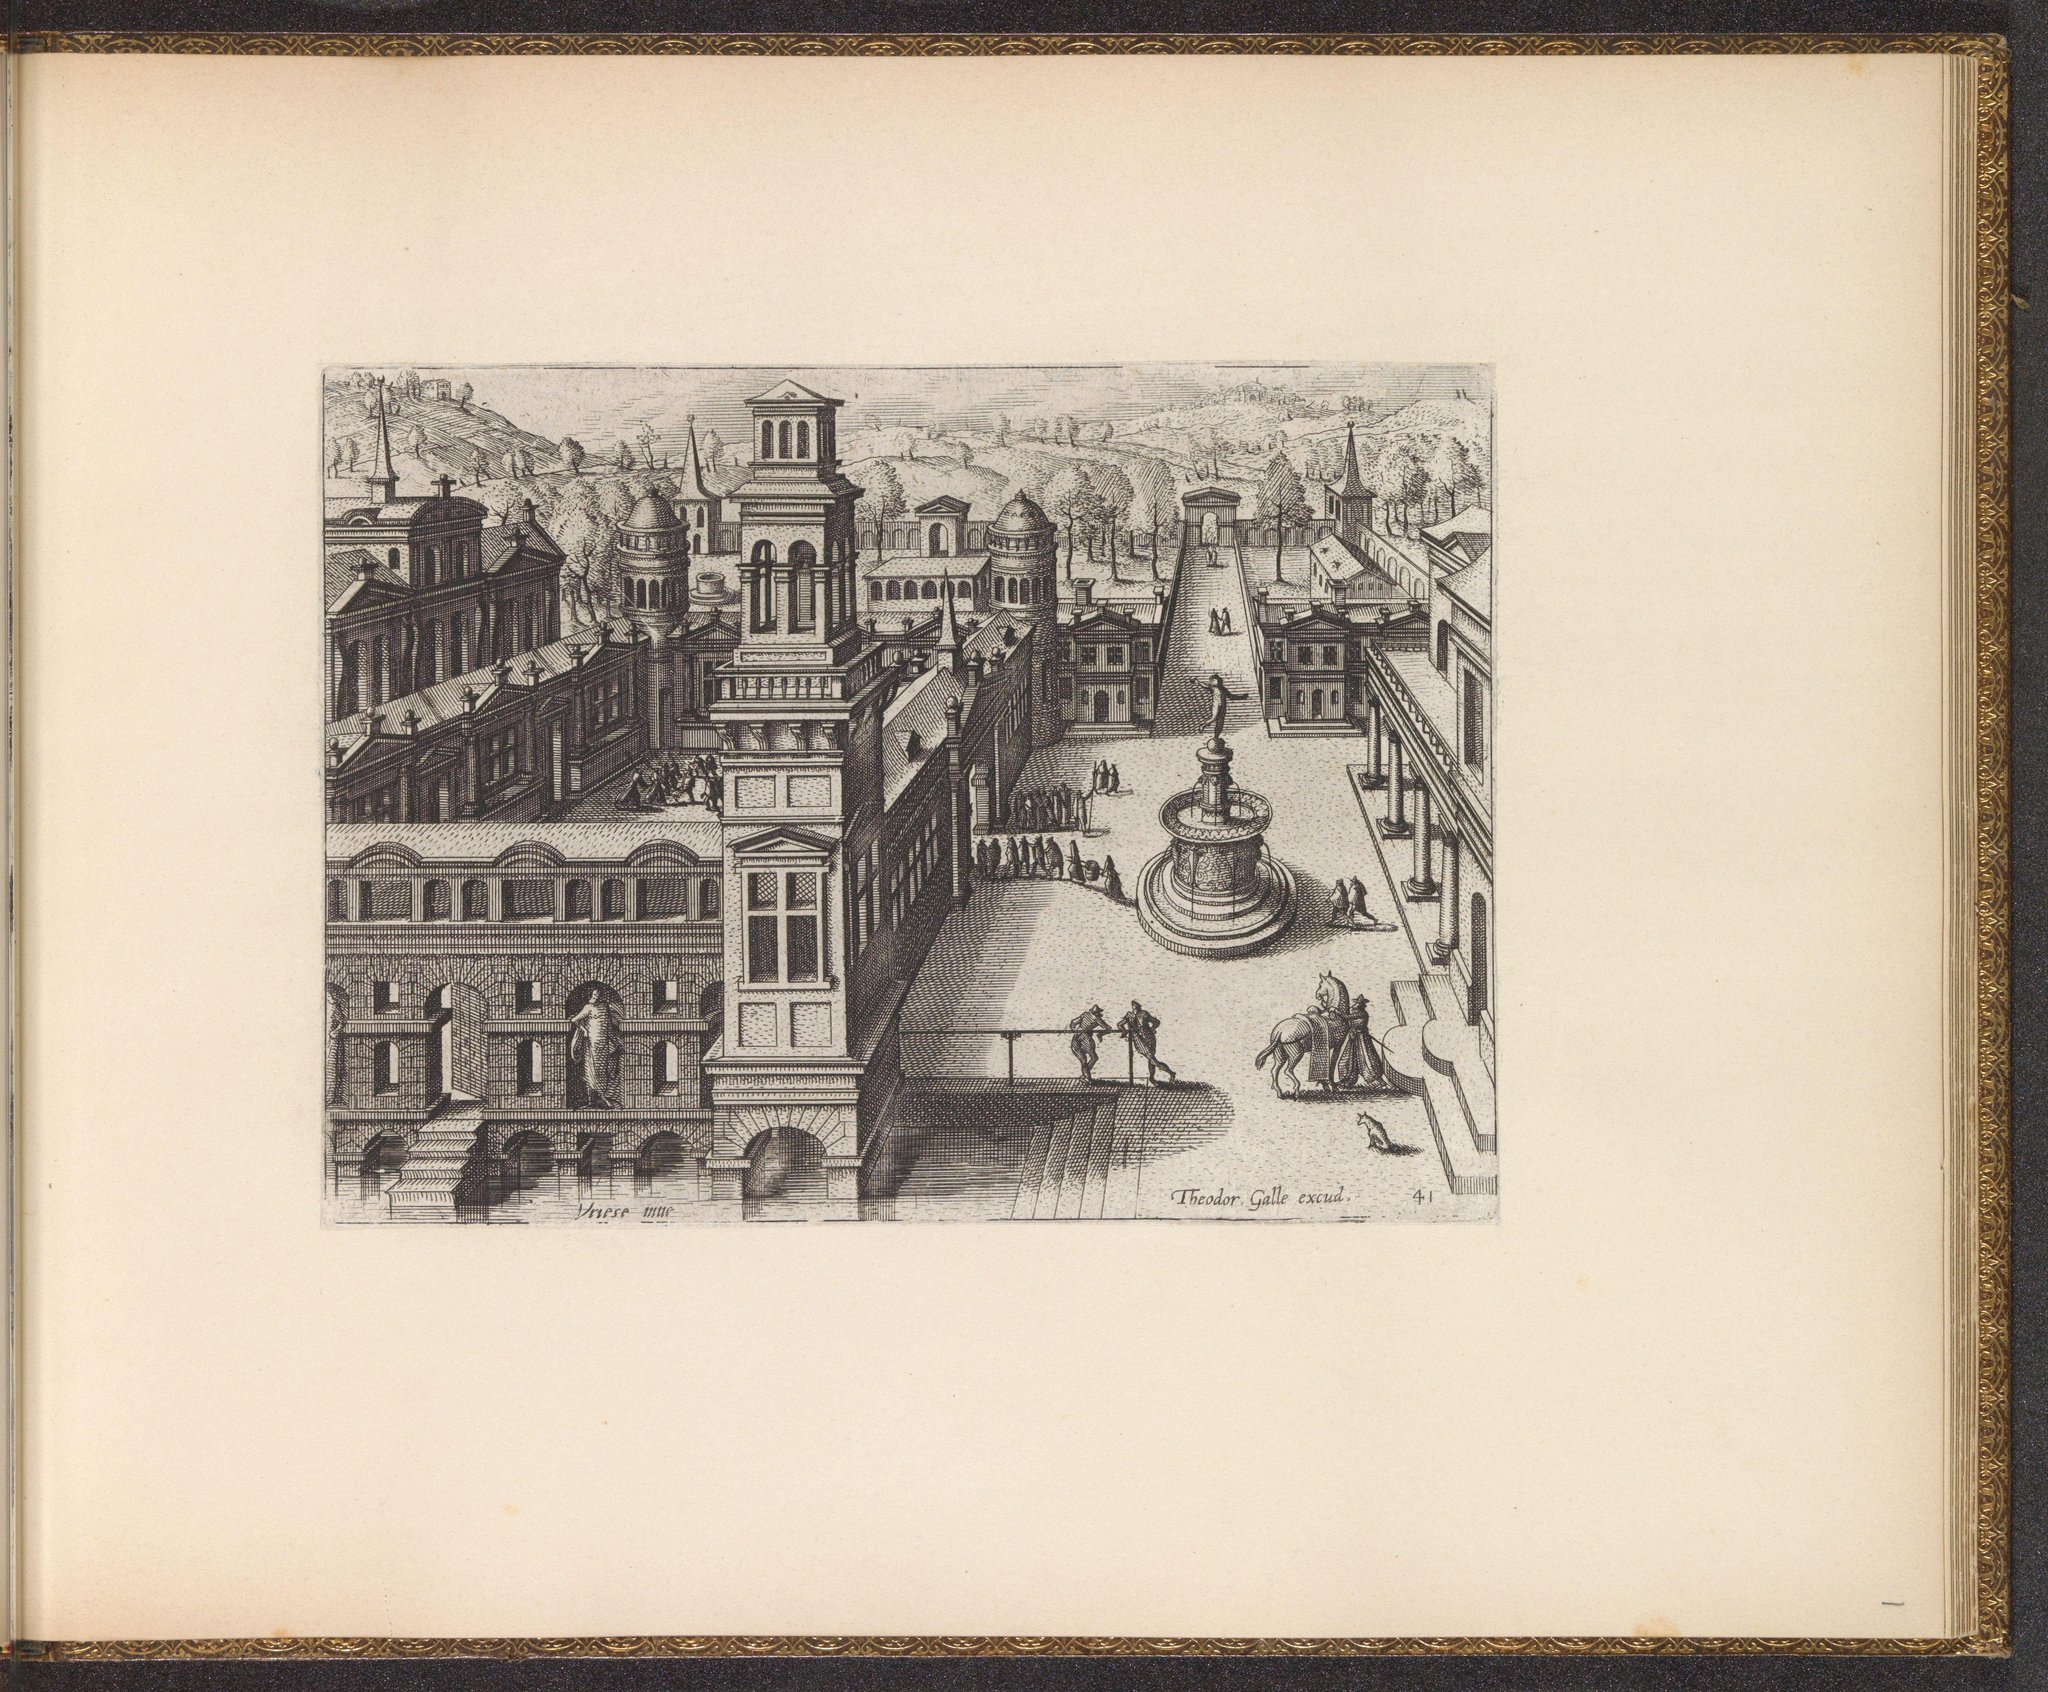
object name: print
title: Paleis met een binnenplaats en een voorplein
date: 1601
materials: paper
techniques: etching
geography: antwerp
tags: garden fountain, palace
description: Paleis met een binnenplaats en een voorplein met een fontein in semi-vogelvlucht. Rechts op de voorgrond staat een man met een paard. De prent maakt deel uit van een album.